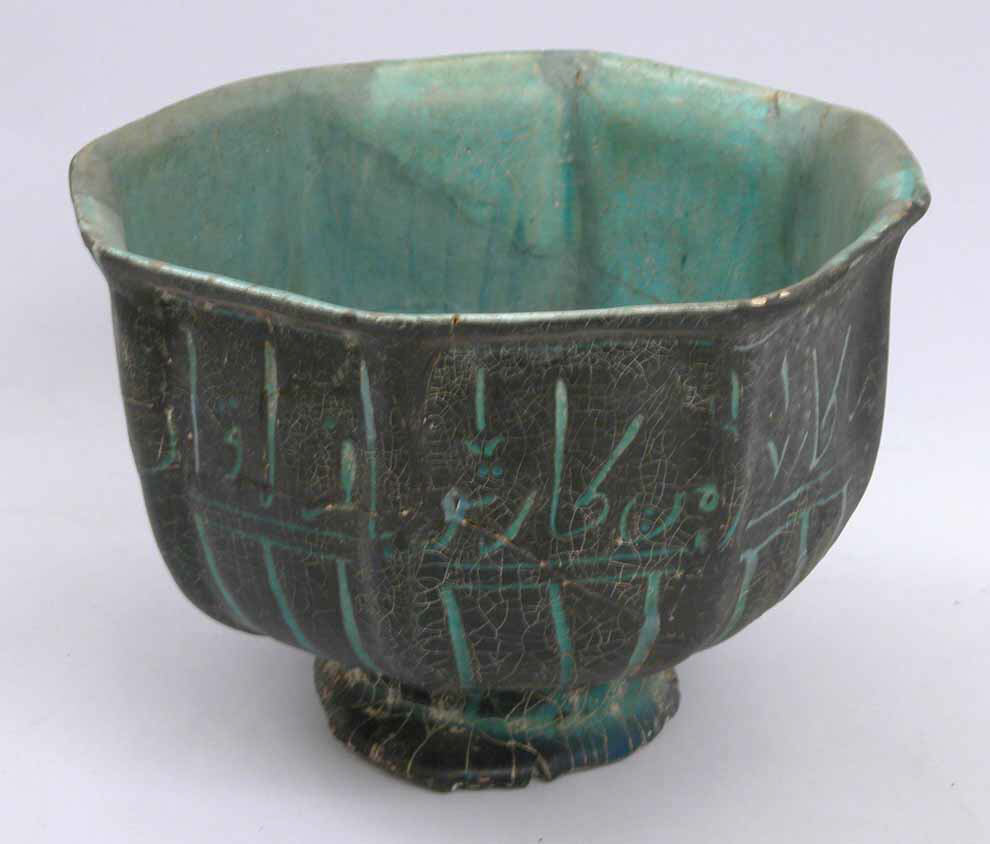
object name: bowl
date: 1201-1300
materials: stonepaste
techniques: glazing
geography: iran